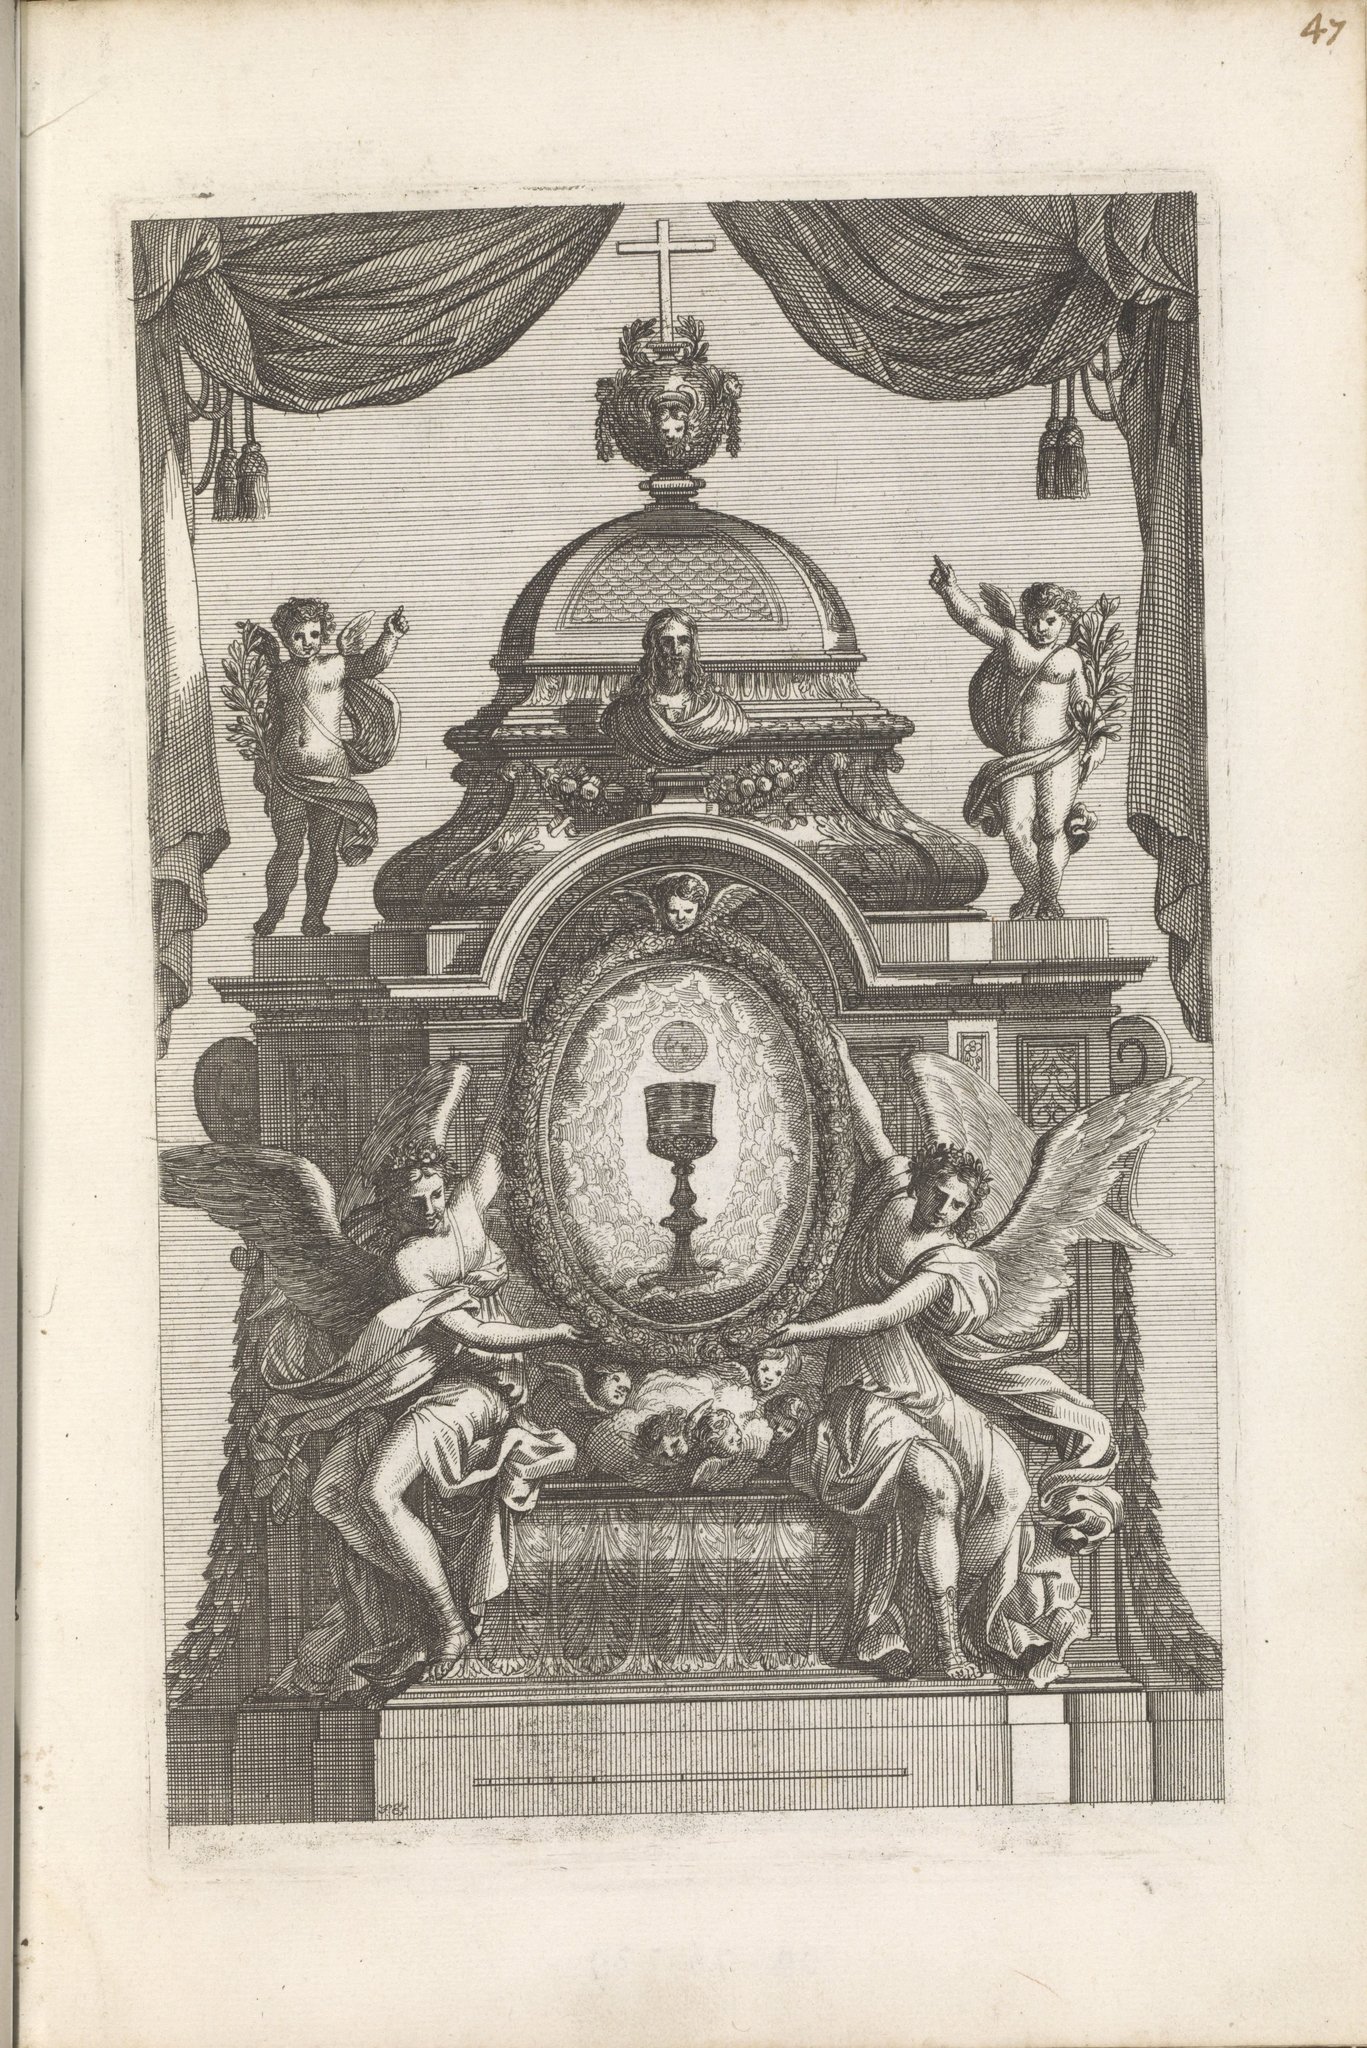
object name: album leaf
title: Tabernacoli da ornare e abellire di Altari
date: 1658-1678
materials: paper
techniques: etching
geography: antwerp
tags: tabernacle ~ altar, chalice bearing the host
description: Tabernakel met twee engelen die een medaillon met kelk en hostie tonen. Op de architraaf een Christusbuste. Prent maakt deel uit van een album.